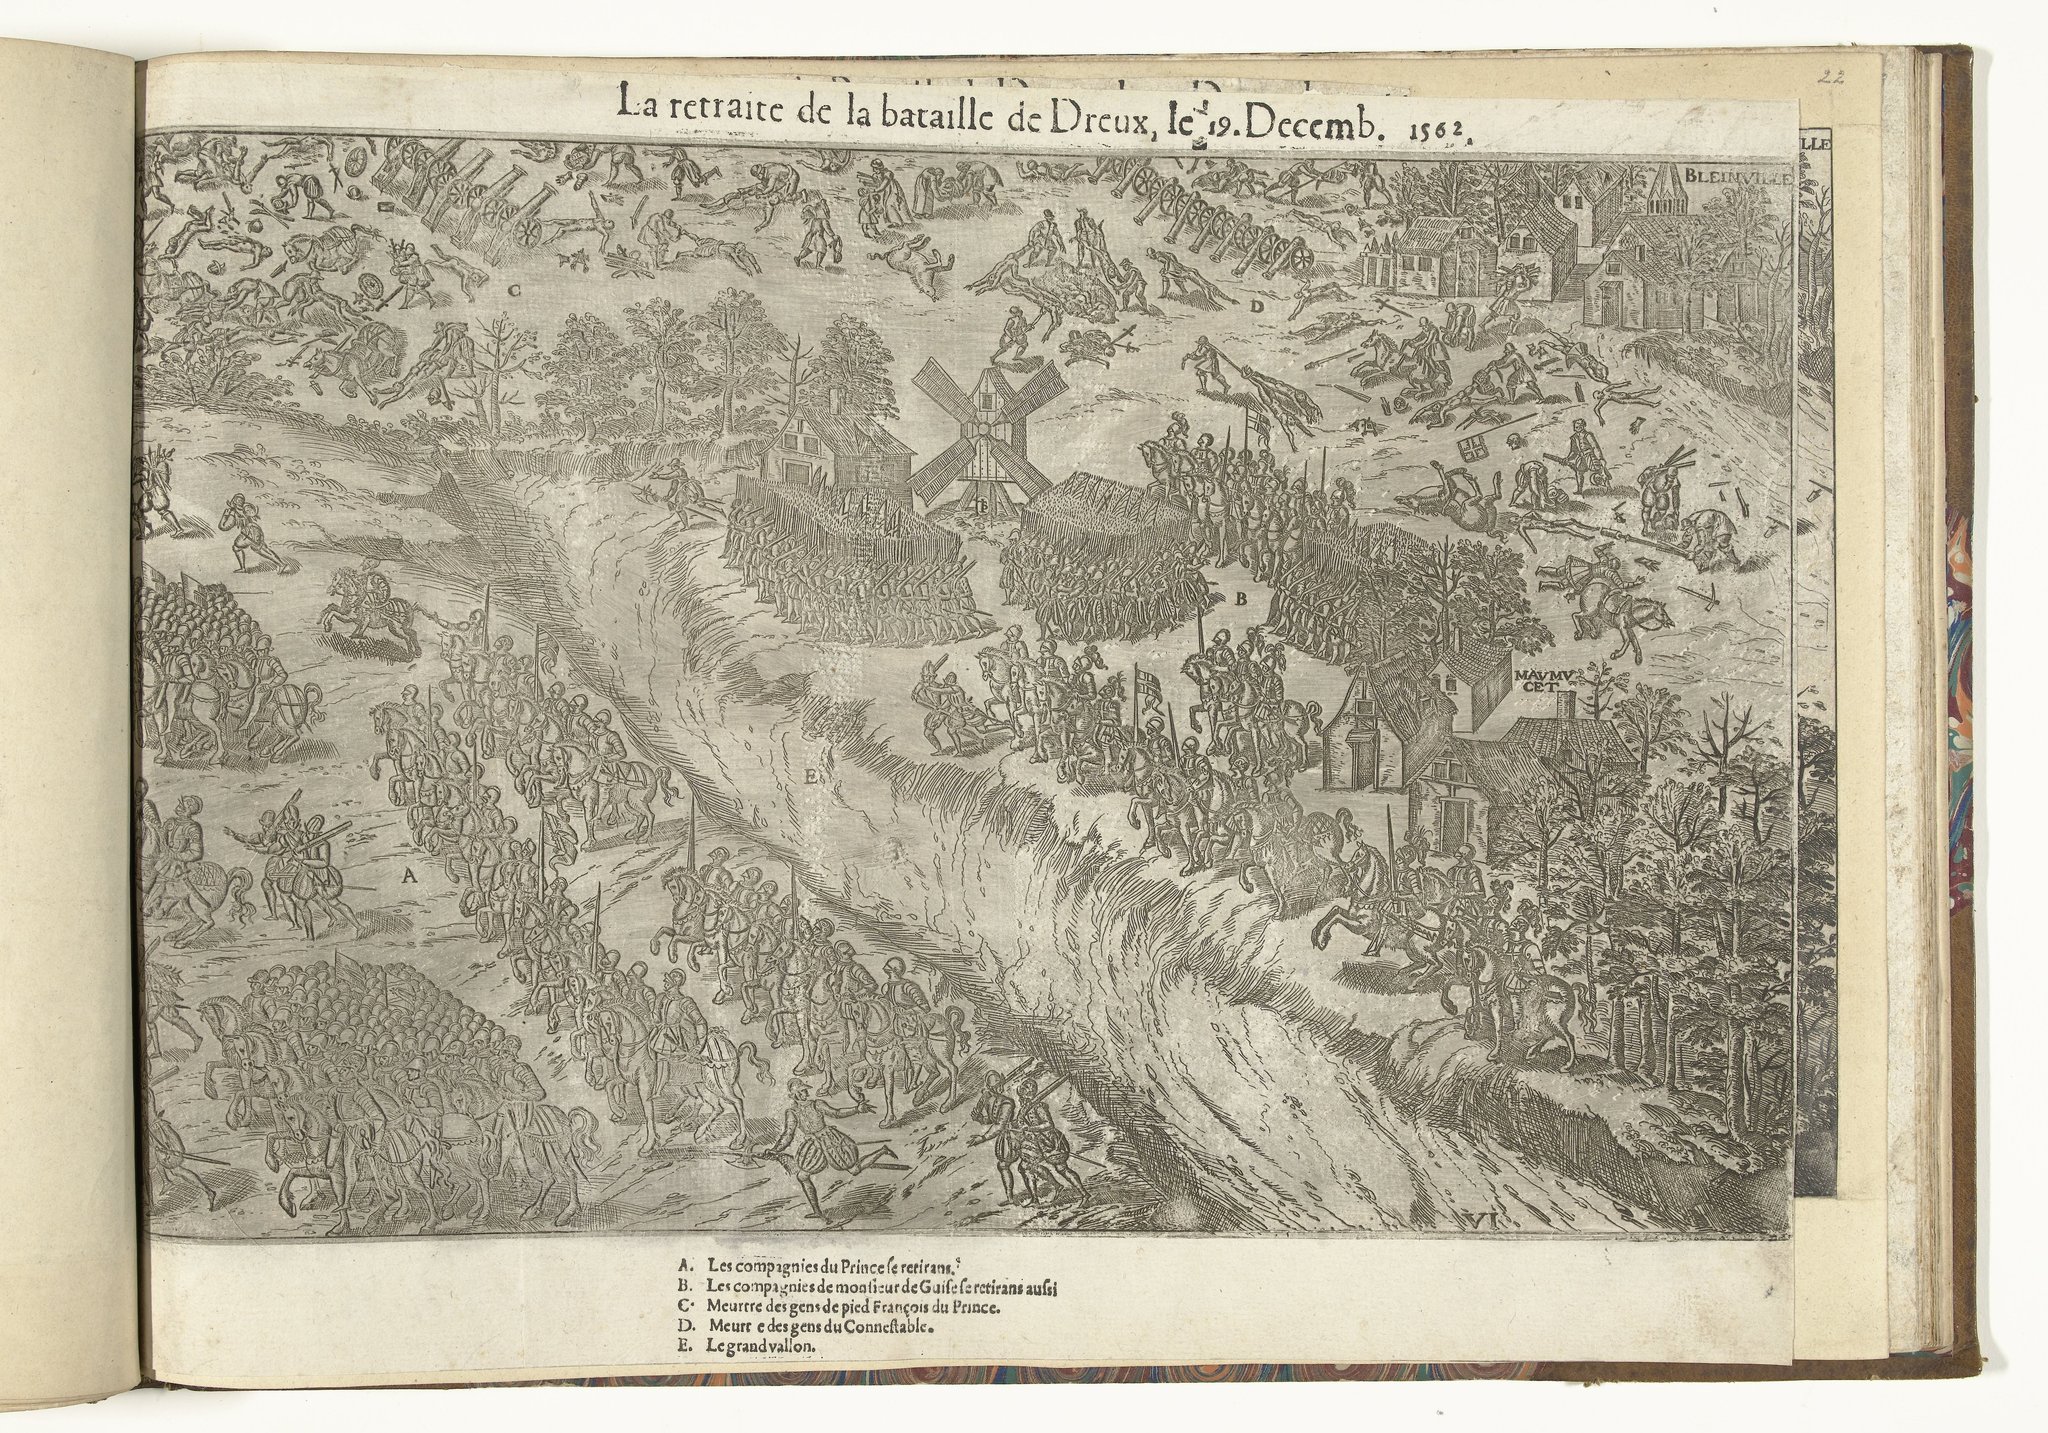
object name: history print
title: Aftocht na de slag bij Dreux, 1562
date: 1570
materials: paper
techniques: etching, letterpress printing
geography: france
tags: after the battle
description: Aftocht na de slag bij Dreux tussen de hugenoten en de katholieken, 19 december 1562. De legers verlaten het slagveld. In het onderschrift de legenda A-E in het Frans. Ongenummerd.